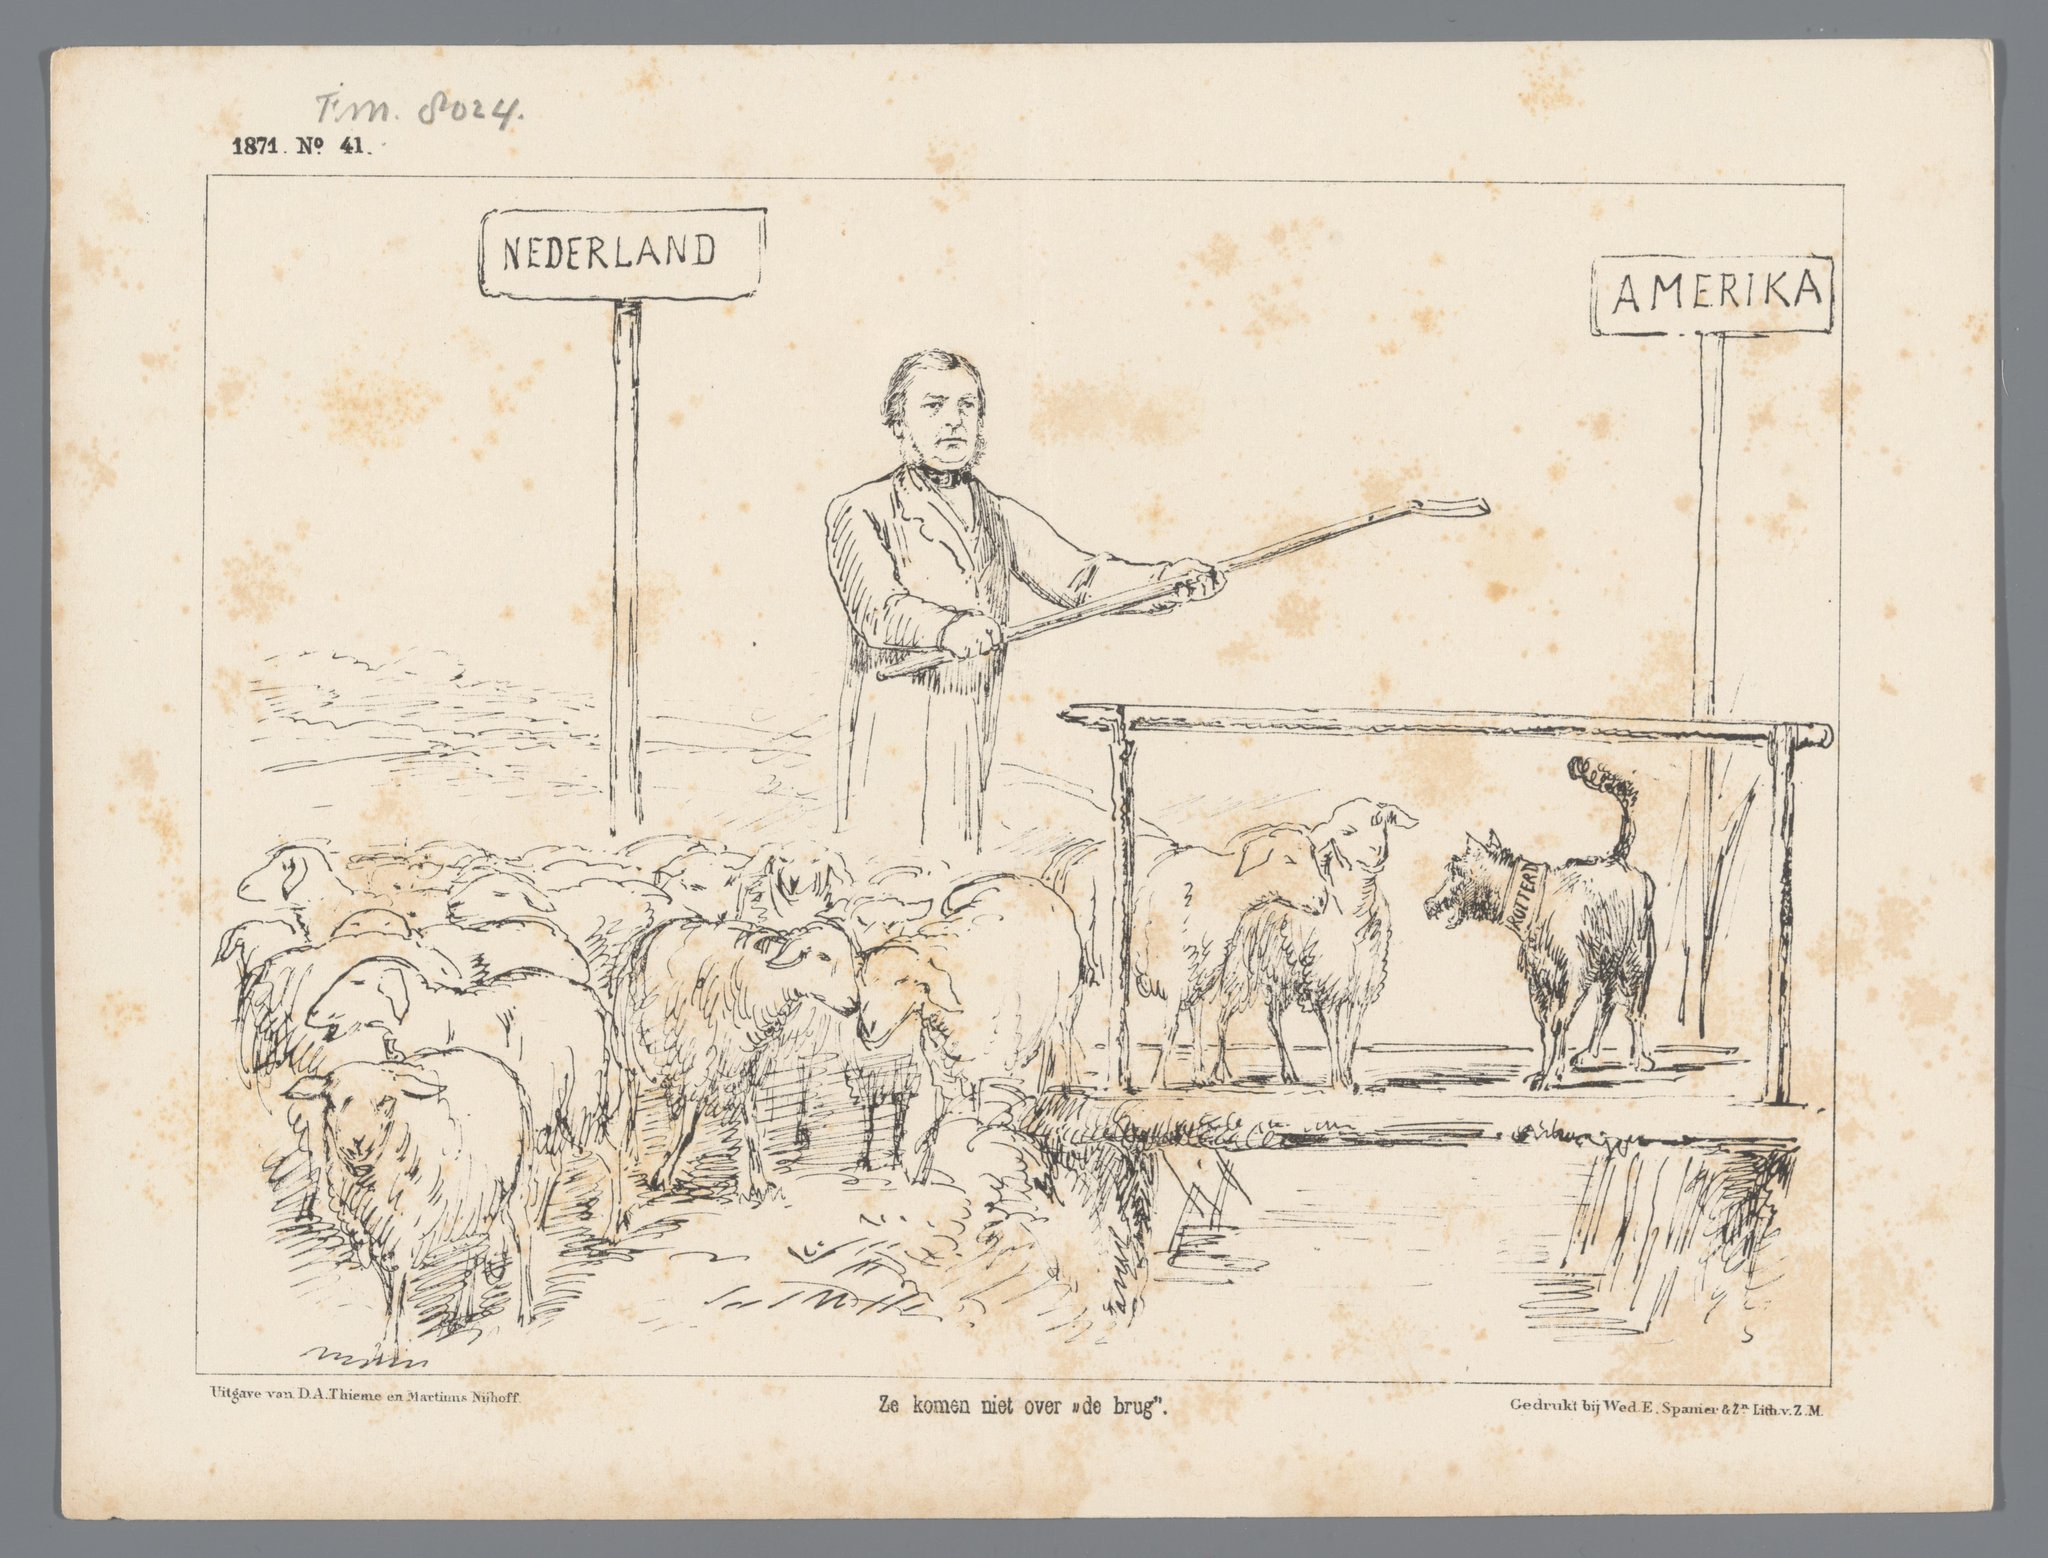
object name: print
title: Spotprent op de tegenwerking van Rotterdam tegen het de stoomvaart tussen Vlisssingen en New York, 1871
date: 1871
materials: paper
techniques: lithograph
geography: netherlands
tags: herding, herdsman, herdswoman, shepherd, shepherdess, cowherd, etc., rotterdam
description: Spotprent op het vewerpen in de Tweede Kamer van het plan voor het opzetten van stoomvaart tussen Vlisssingen en New York door de tegenwerking van Rotterdam. Kamervoorzitter Dullert probeert als herder tevergeefs de schapen over de dam te krijgen. Plaat verschenen bij het weekblad De Nederlandsche Spectator, nr. 41, 1871.